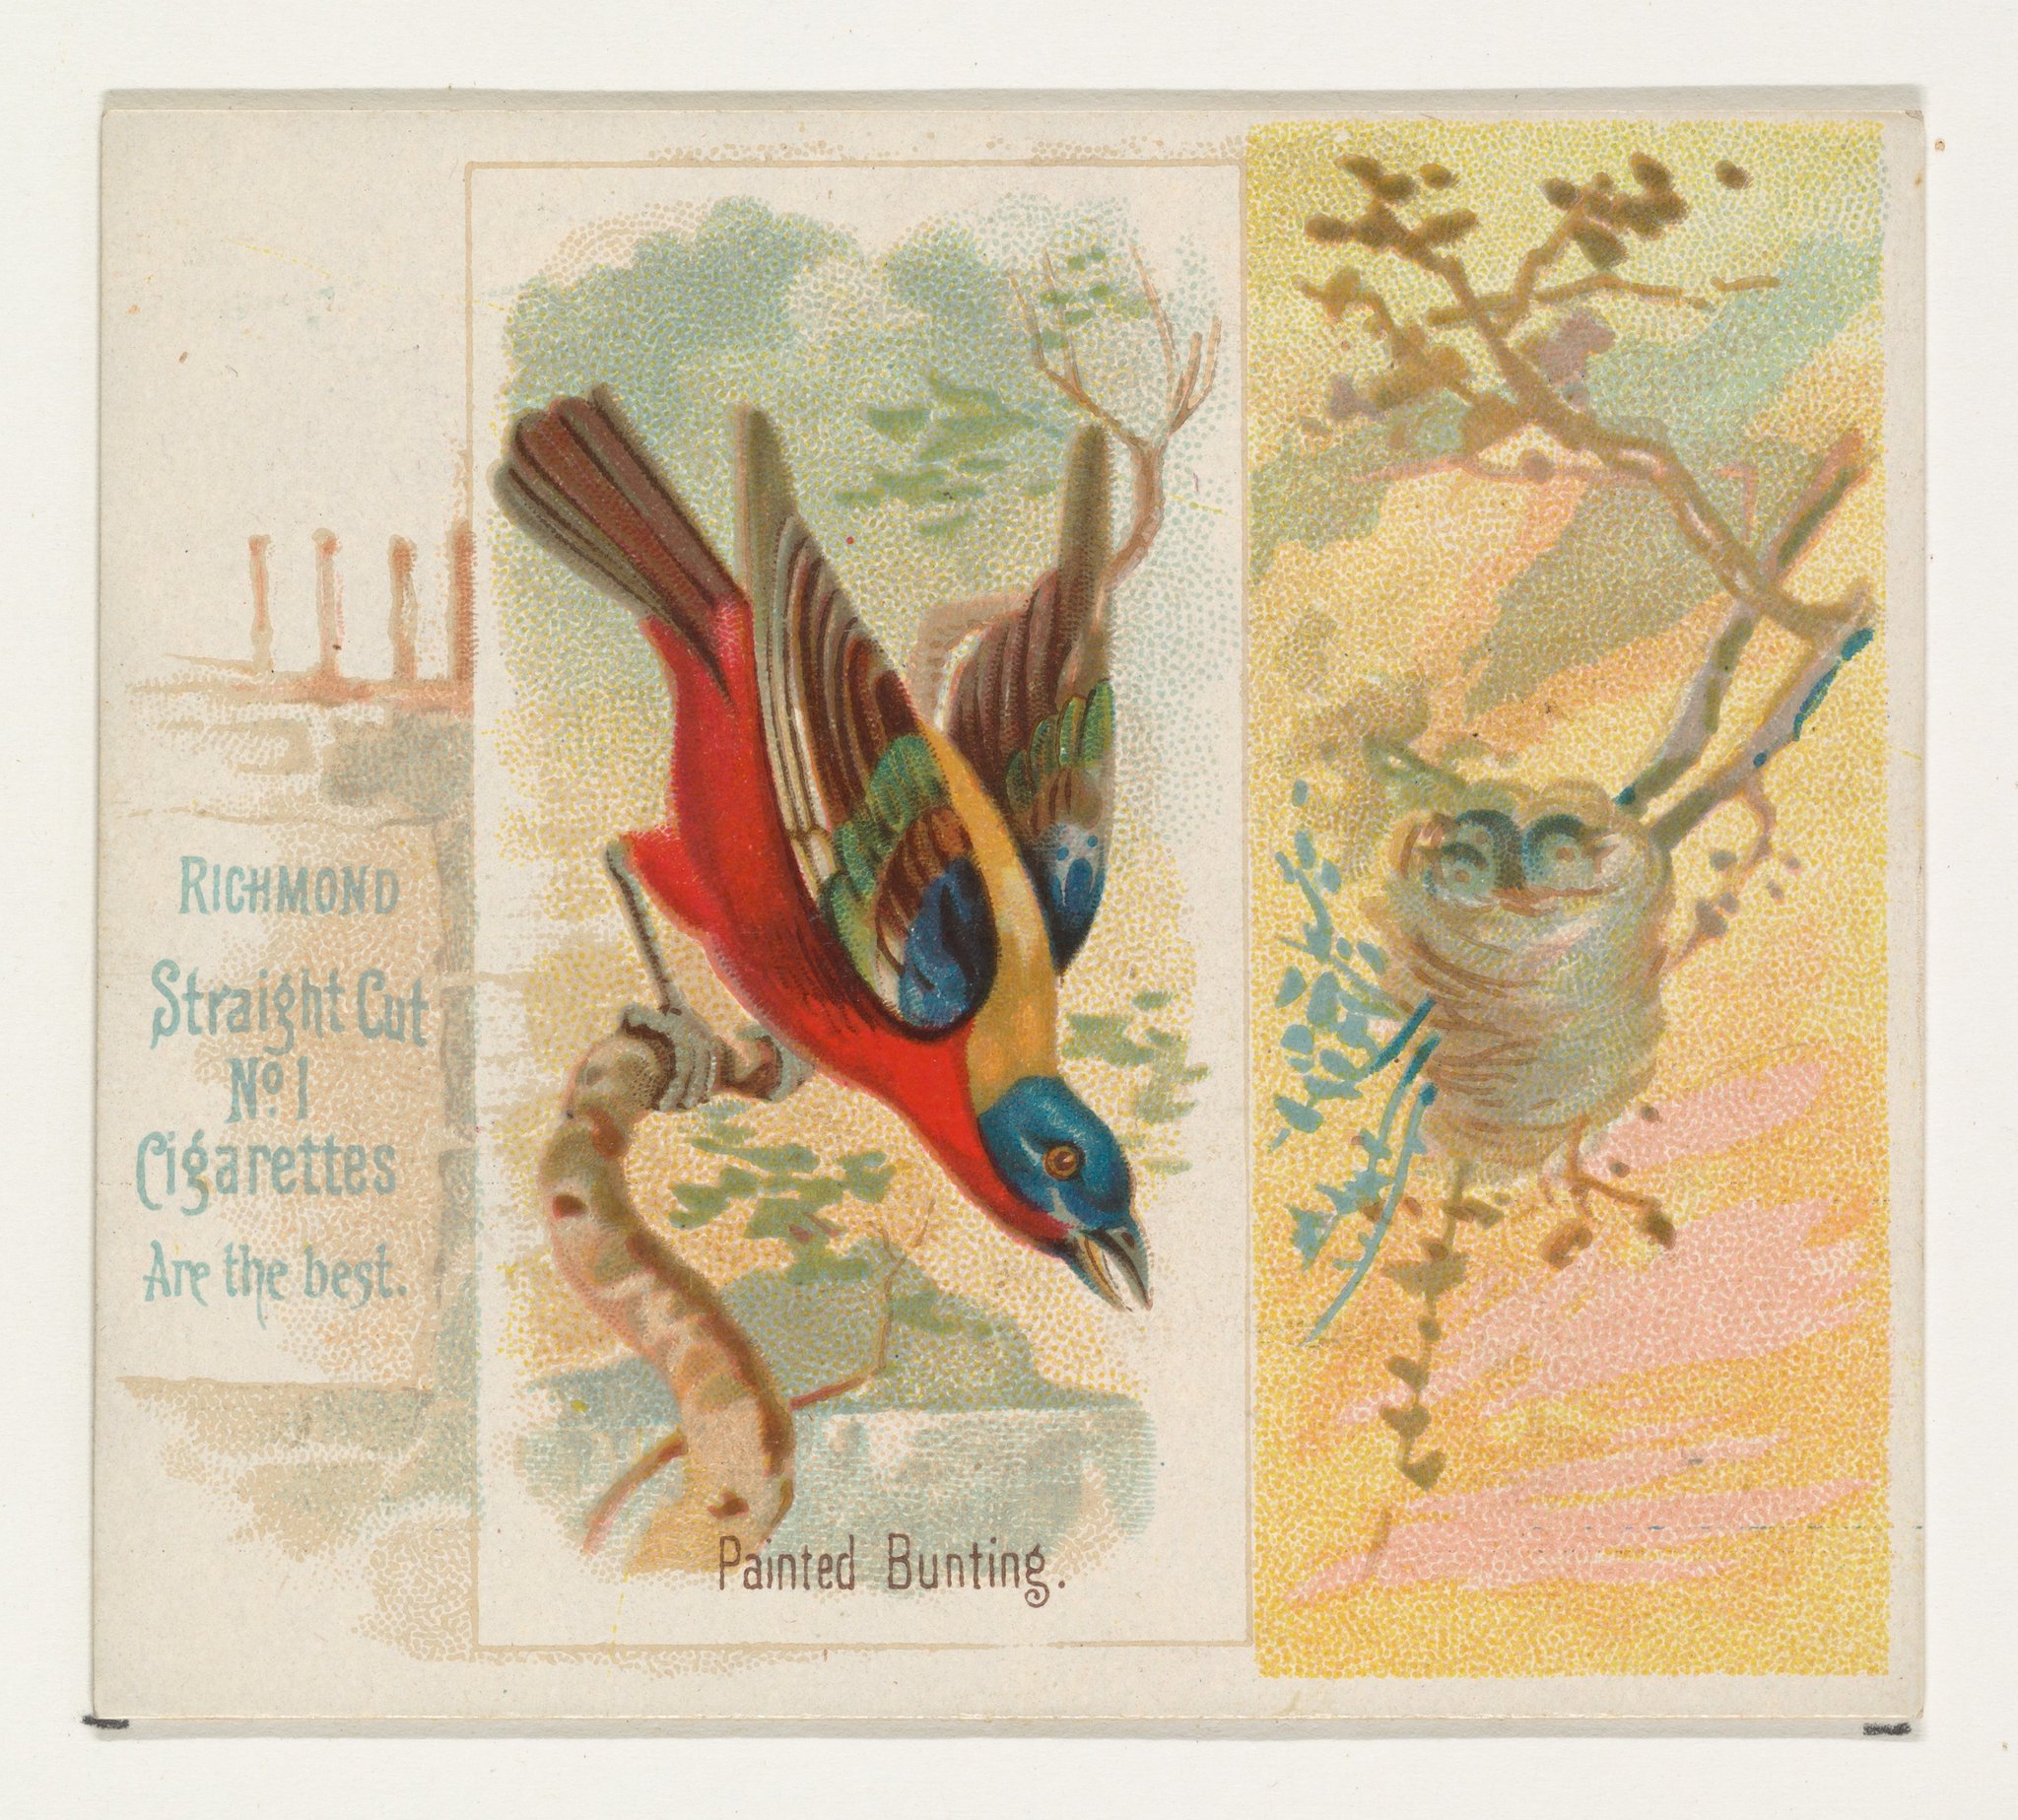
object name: print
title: Painted Bunting, from the Song Birds of the World series (N42) for Allen & Ginter Cigarettes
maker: allen & ginter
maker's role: publisher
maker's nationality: american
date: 1890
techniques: color lithograph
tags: birds